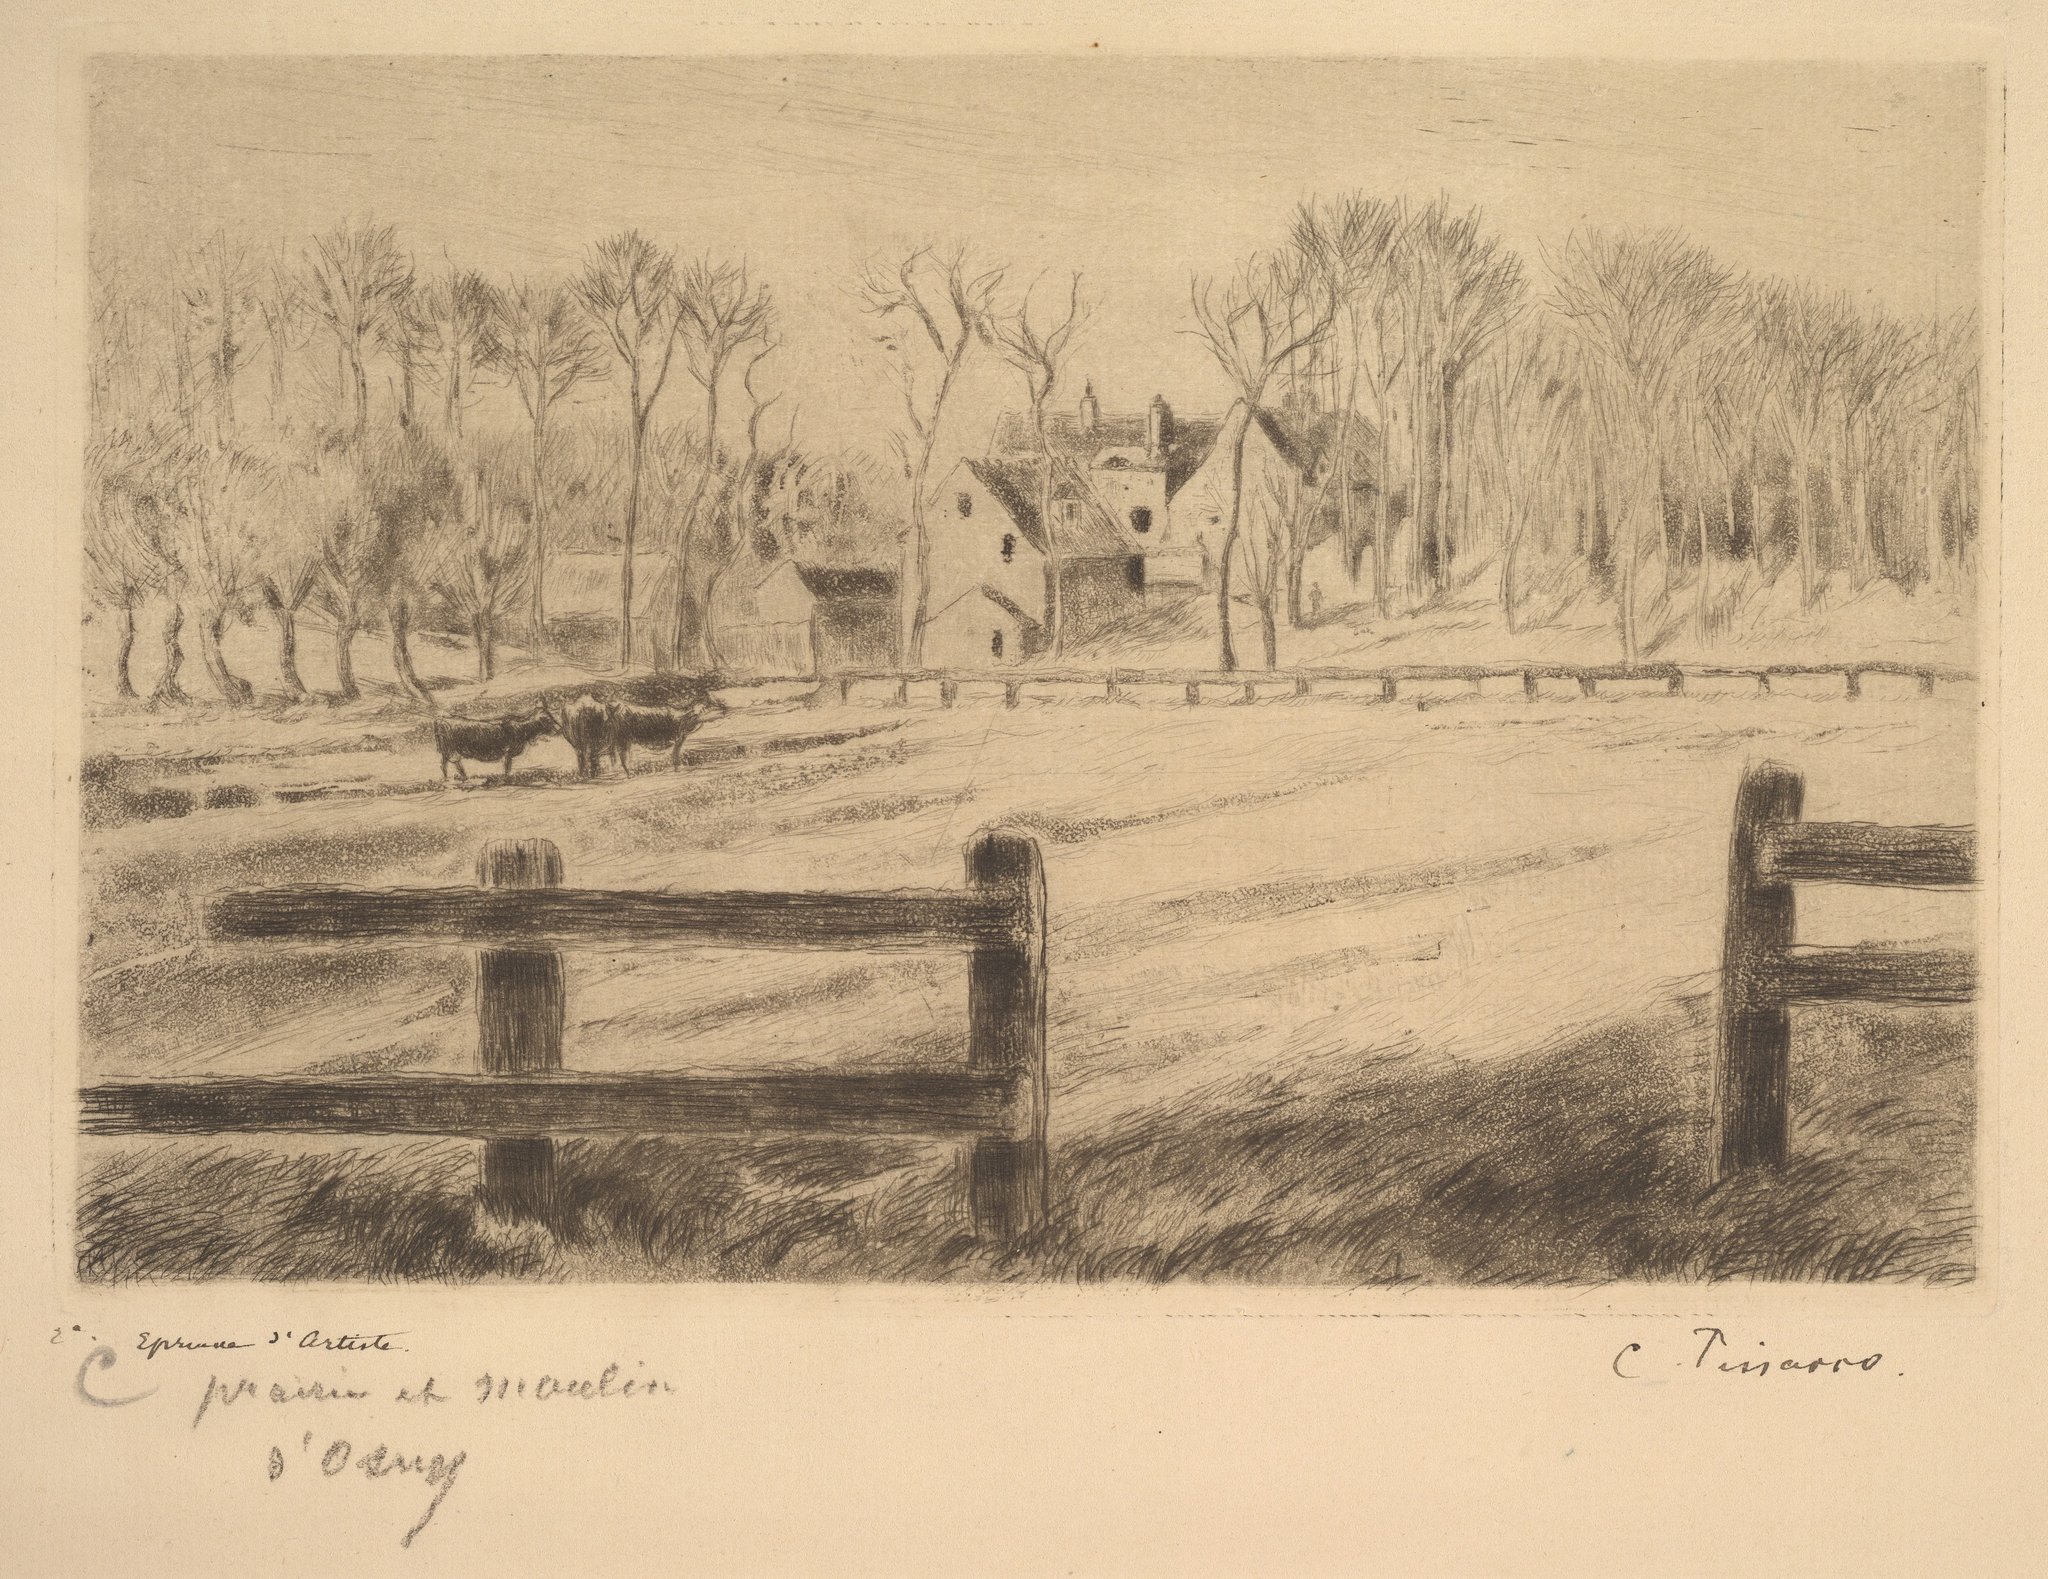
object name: print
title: Field and Mill at Osny, 1885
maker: camille pissarro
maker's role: artist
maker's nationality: french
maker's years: 1830-1903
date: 1885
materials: paper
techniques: aquatint, drypoint, etching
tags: fences,houses,cows